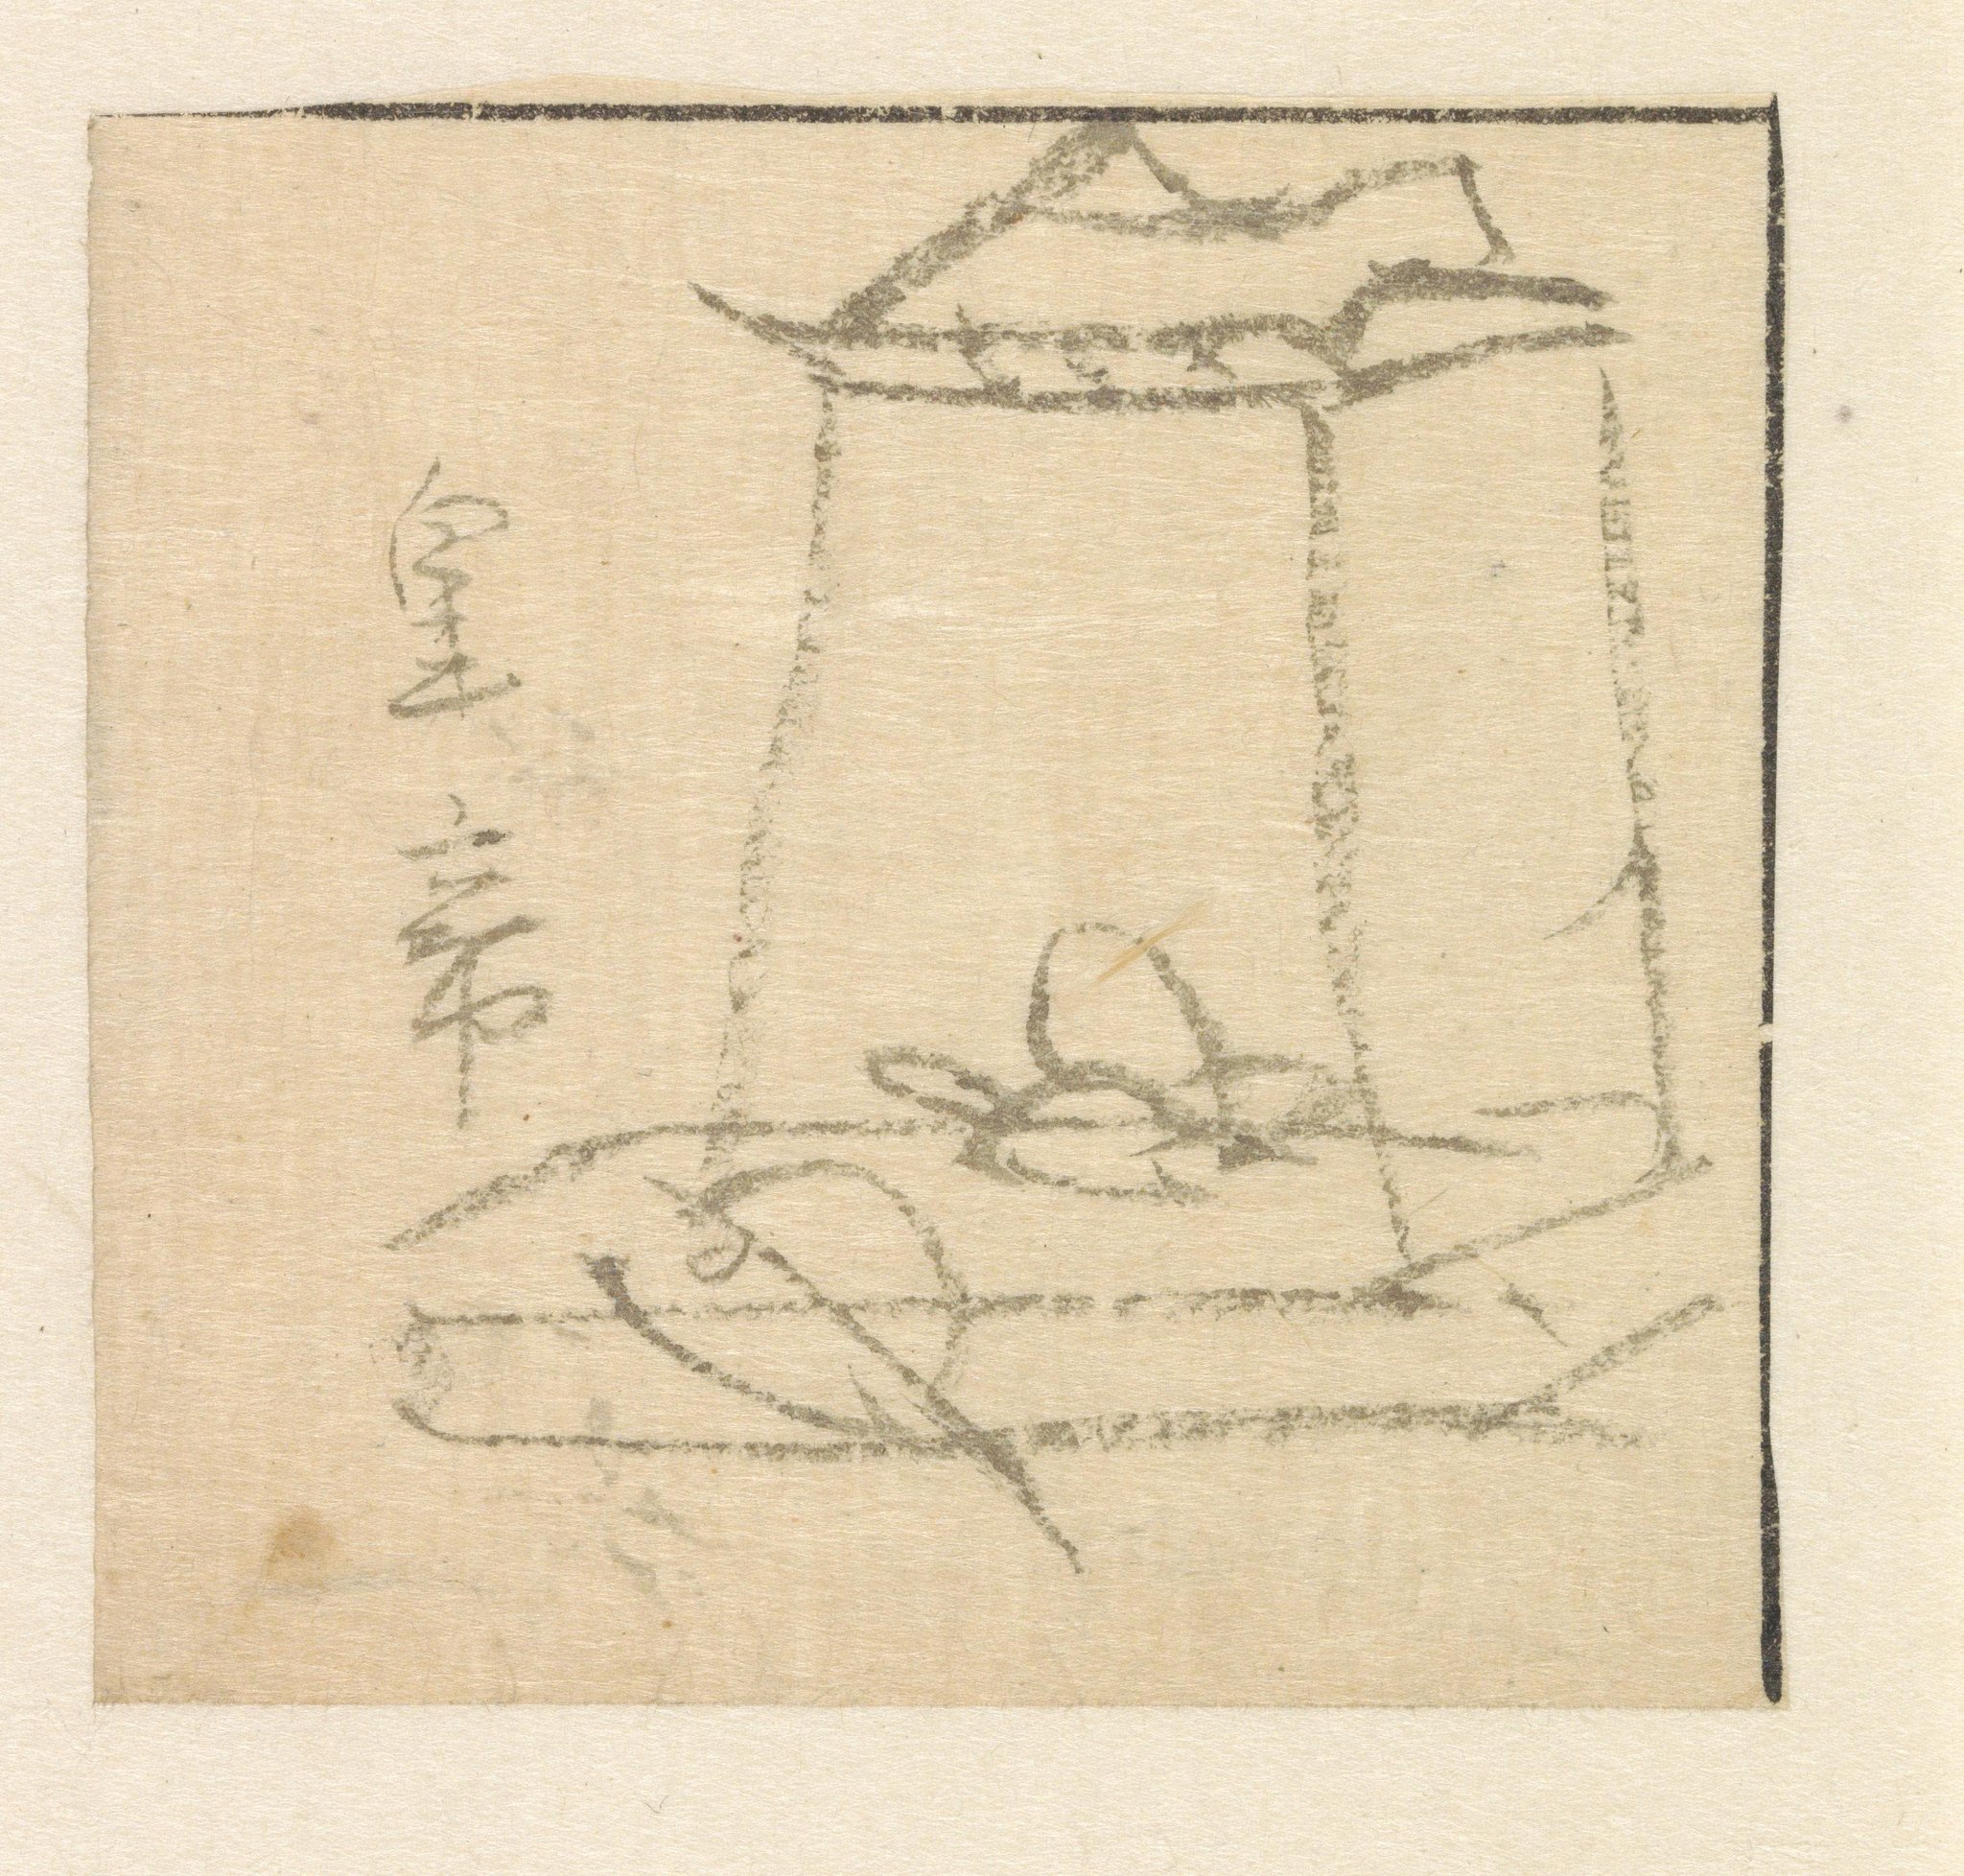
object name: drawing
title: Schetsblad met draagstoel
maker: utagawa hiroshige (i)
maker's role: draughtsman, print maker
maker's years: 1797-1858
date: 1807-1858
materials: paper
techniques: brush